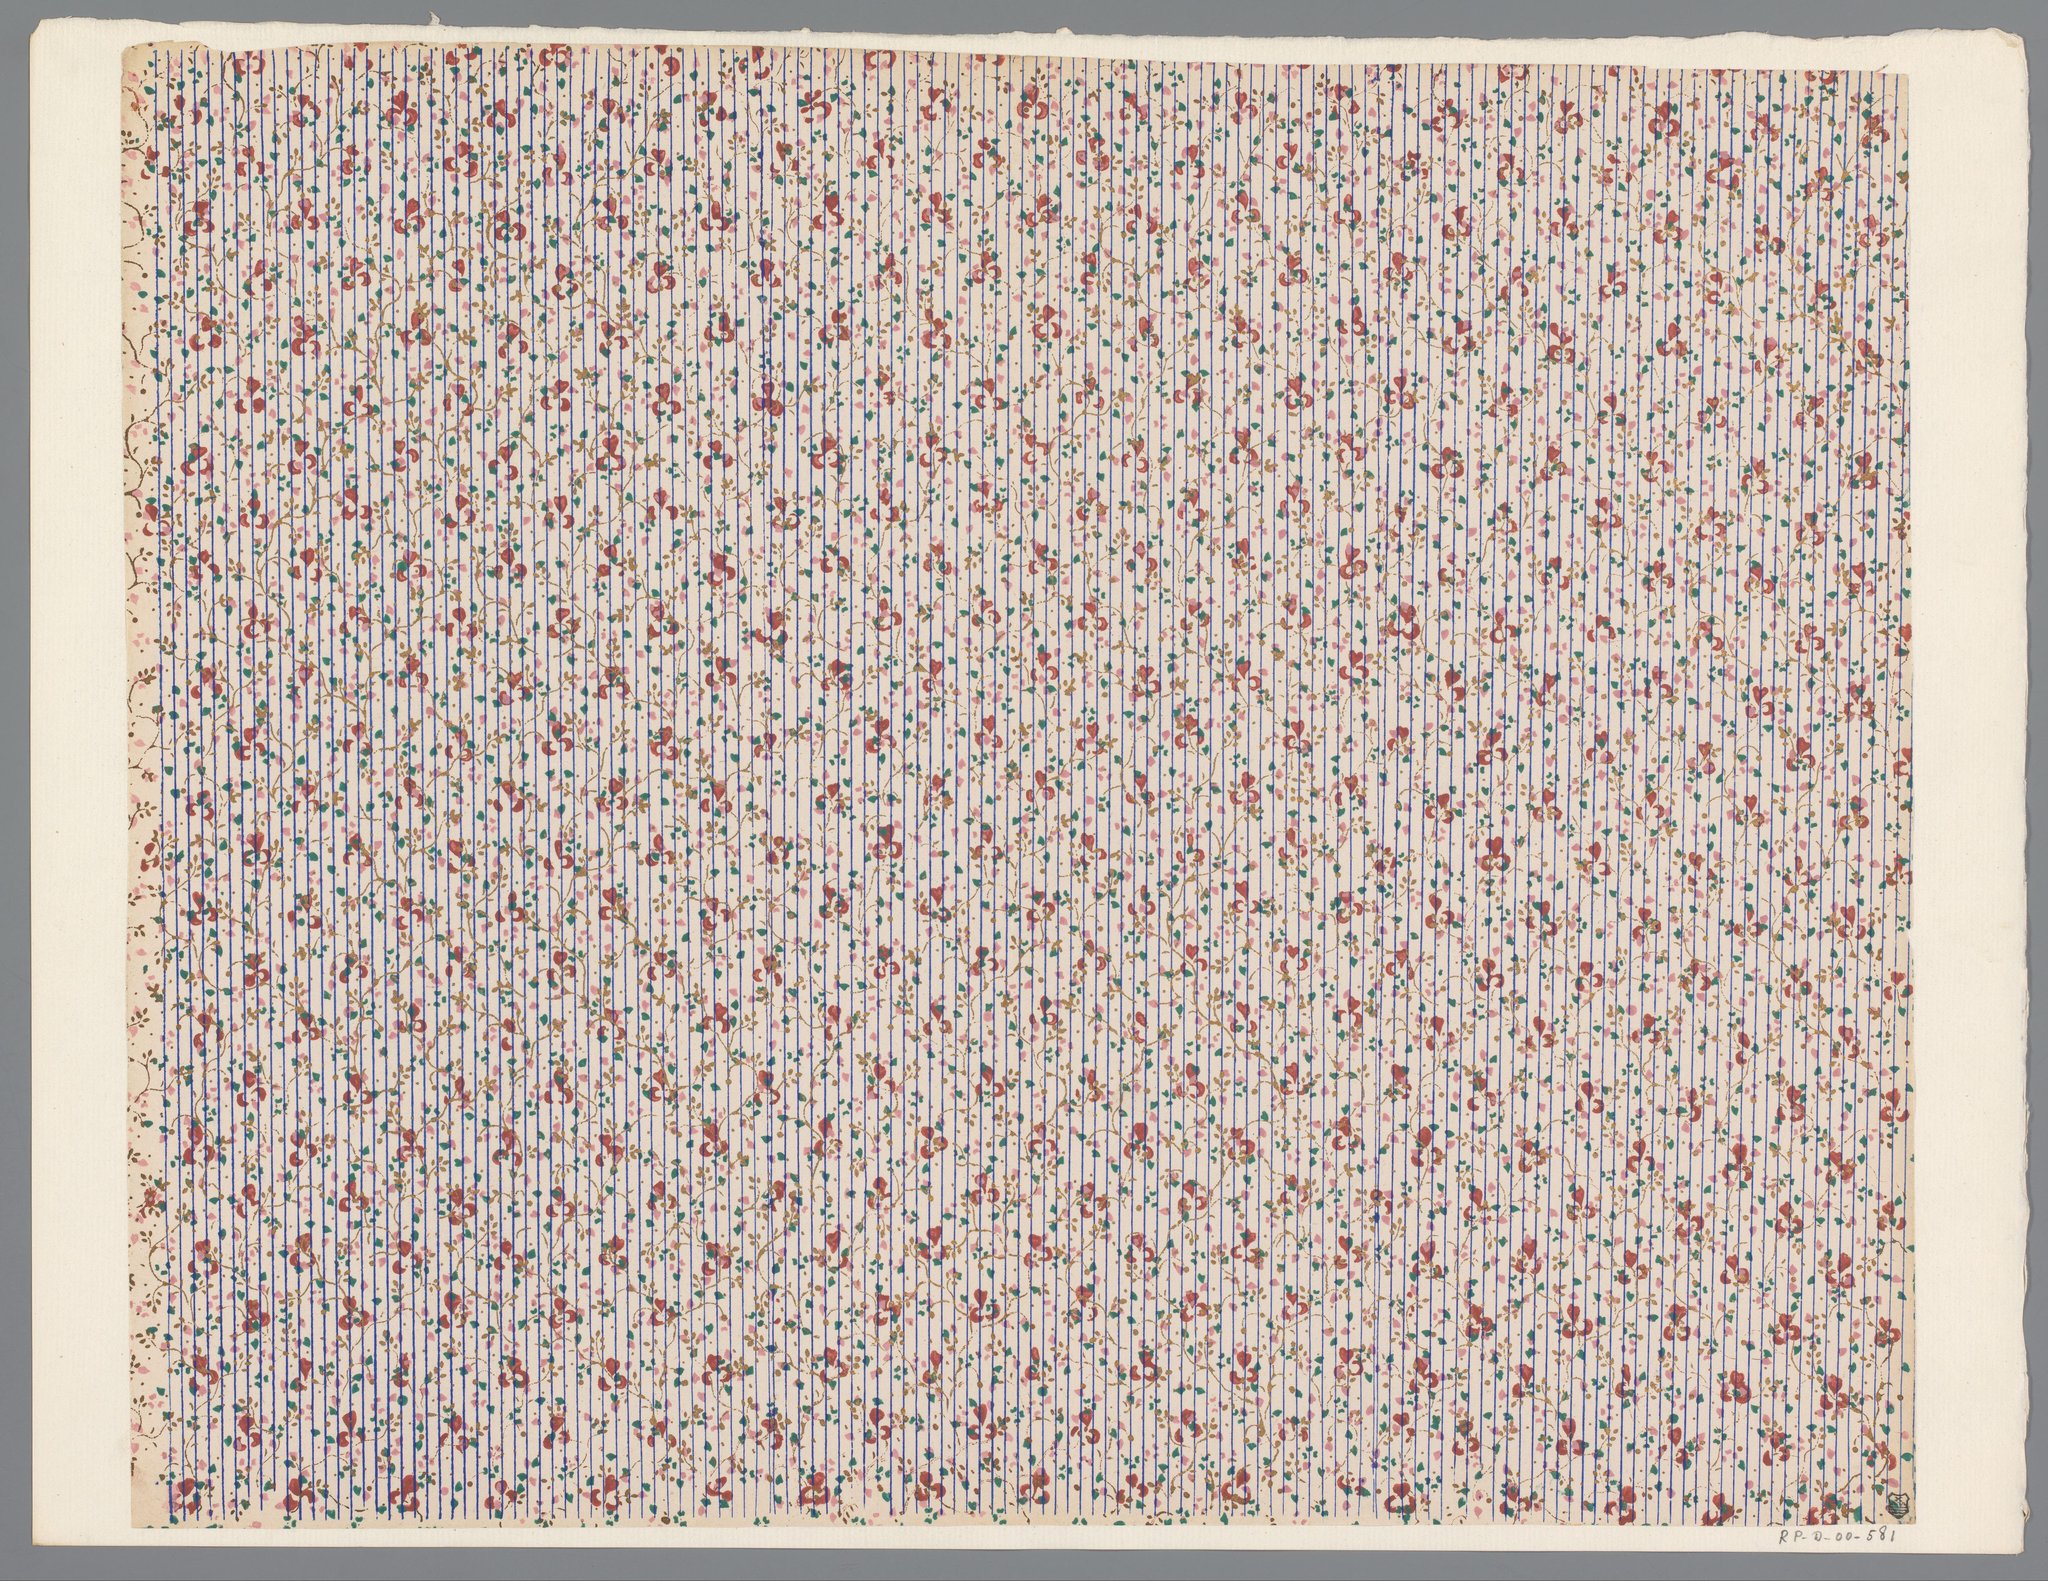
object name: printed paper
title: Blad met strooipatroon van bloemmotief met ranken en lijnenfond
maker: Anonymous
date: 1800-1900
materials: paint, paper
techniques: printing block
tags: ornament derived from plant forms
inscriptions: collector's mark: Lugt 2760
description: Blad met strooipatroon van bloemmotief met ranken over een verticaal lijnenfond.